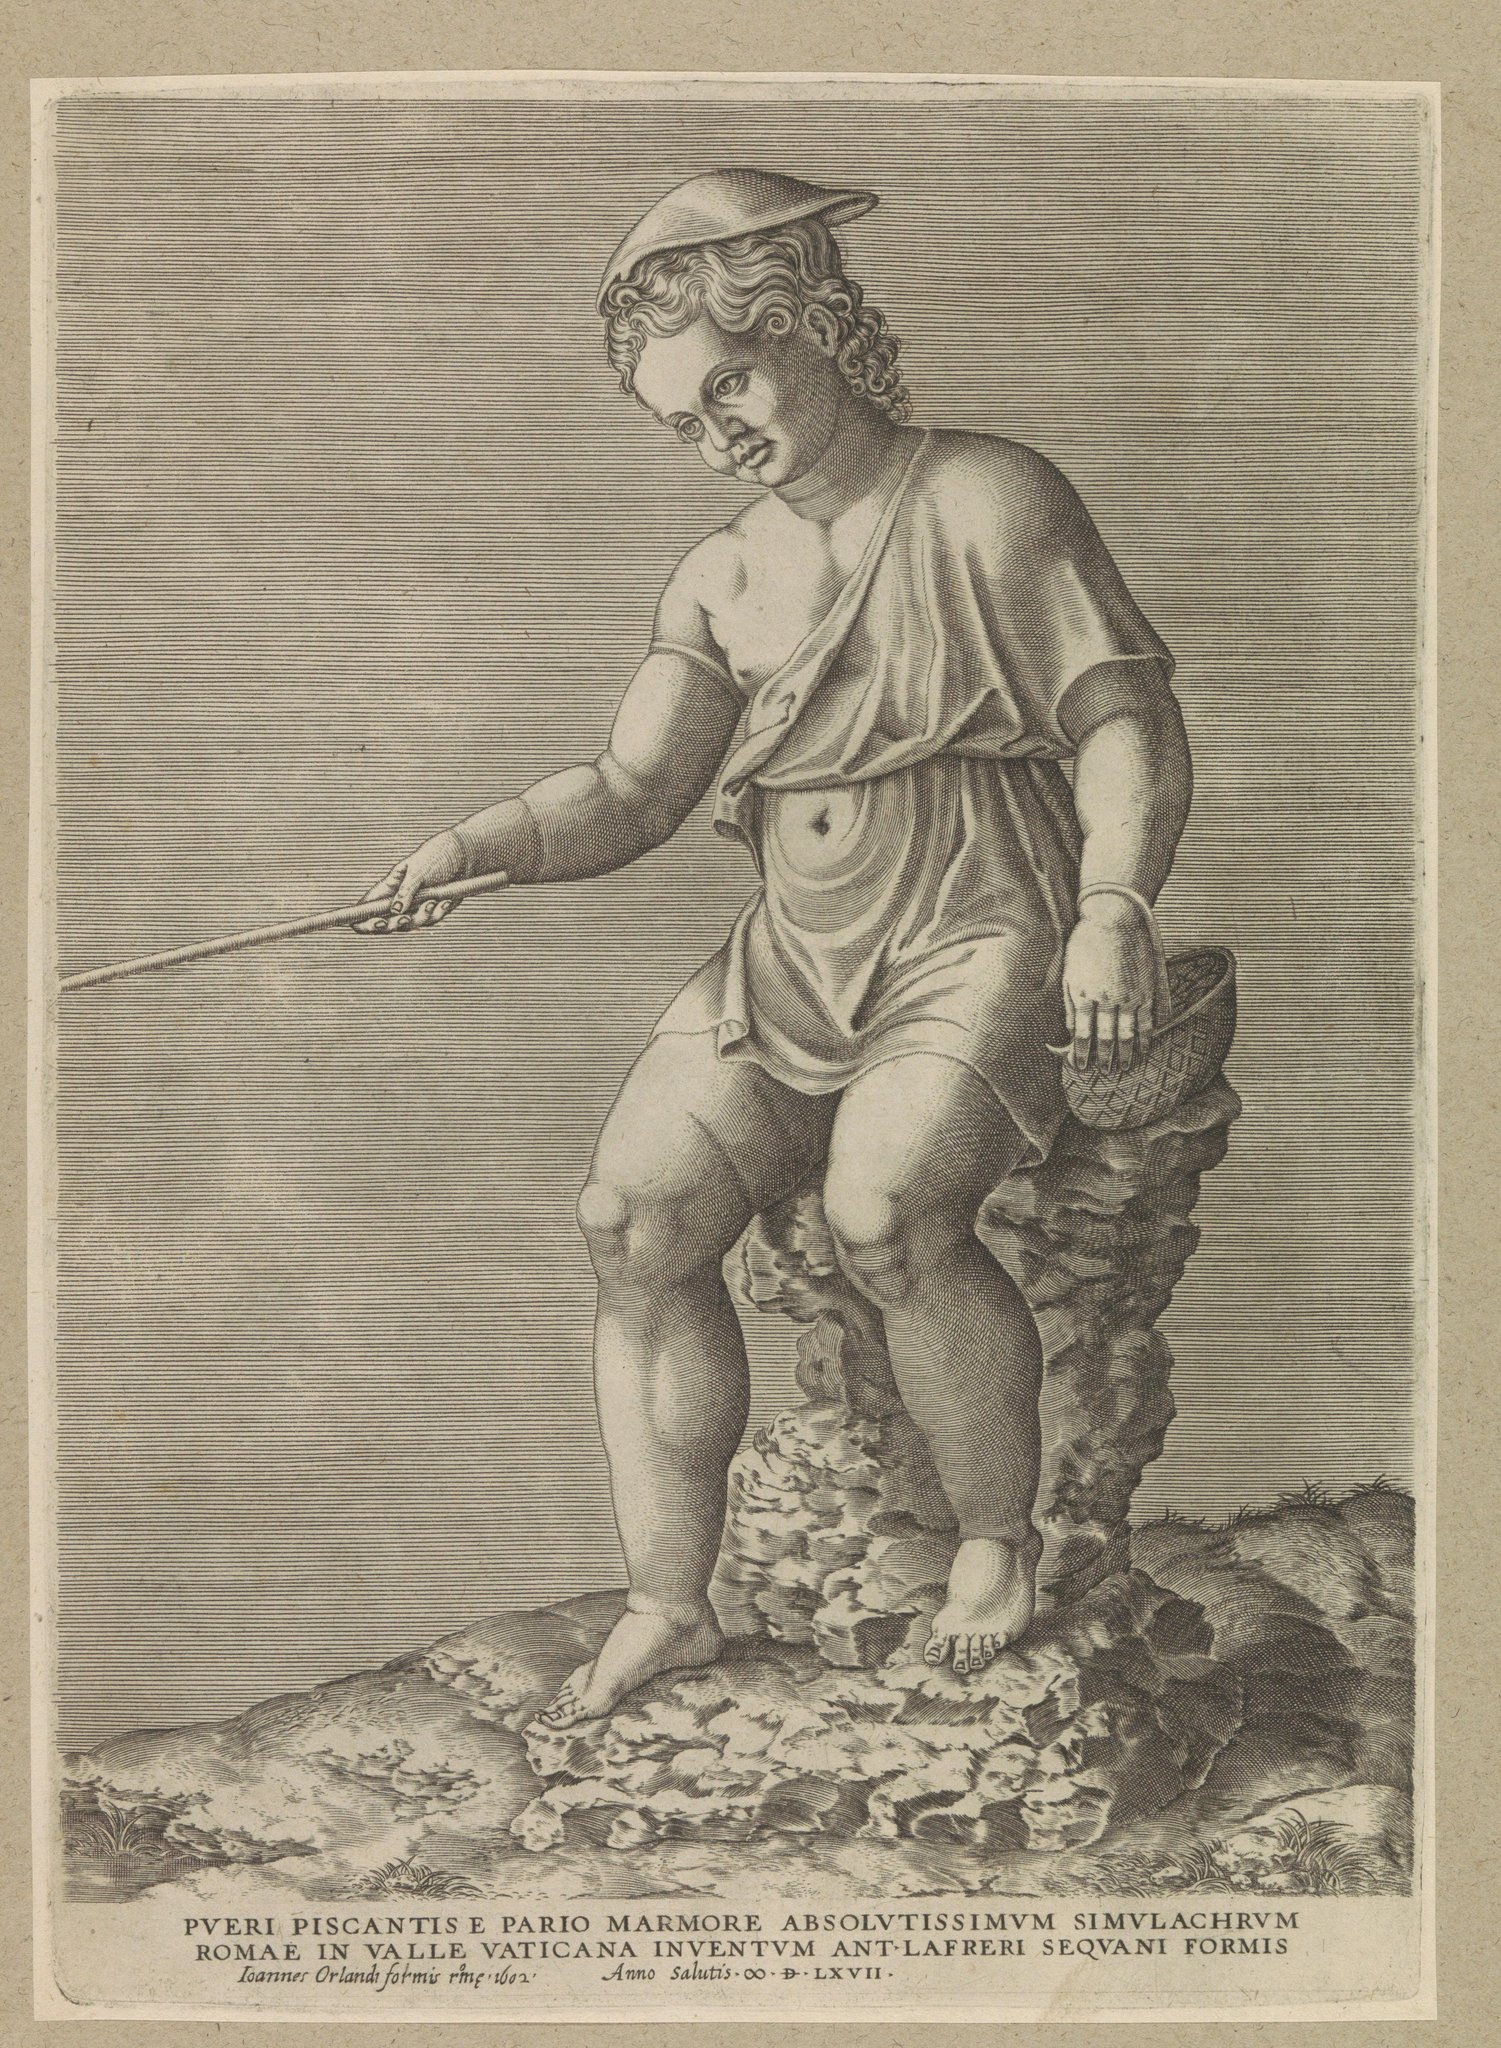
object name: album leaf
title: Pueri piscantis e pario marmore absolutissimum simulachrum Romae in valle Vaticana inventum Ant. Lafreri sequari formis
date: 1547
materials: paper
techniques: engraving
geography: italy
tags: piece of sculpture, reproduction of a piece of sculpture, fisherman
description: Deze prent behoort tot het prentcorpus dat bekend staat als de ‘Speculum Romanae Magnificentiae’ (‘Spiegel van Romeinse pracht’). Dit corpus, bestaande uit prenten met voorstellingen van kunstwerken en gebouwen uit het antieke en het moderne Rome, vond zijn oorsprong bij uitgevers Antonio Salamanca en Antonio Lafreri. Deze twee buitenlandse uitgevers bundelden hun krachten te Rome in de periode 1553-1563. Hun prenten werden al snel razend populair bij toeristen en verzamelaars, die de prenten individueel of in grote groepen aanschaften. Grote groepen Speculum-prenten werden vaak op aanvraag samengebonden in albums. Er zijn verschillende Speculum-albums overgeleverd die allemaal verschillen van inhoud. Tussen 1573 en 1577 gaf Antonio Lafreri een speciale titelpagina uit (met de titel ‘Speculum Romanae Magnificentiae’) die mensen voor hun verzamelingen konden voegen. Het overlijden van Lafreri in 1577 betekende niet het einde van het corpus. Een groot deel van de koperplaten ging over op Claudio en Stefano Duchetti. De rest raakte verspreid over verschillende andere uitgevers. De populariteit van de Speculum-prenten wist nog geruime periode uitgevers te inspireren tot het laten maken van kopieën en het toevoegen van nieuwe prenten aan het corpus.